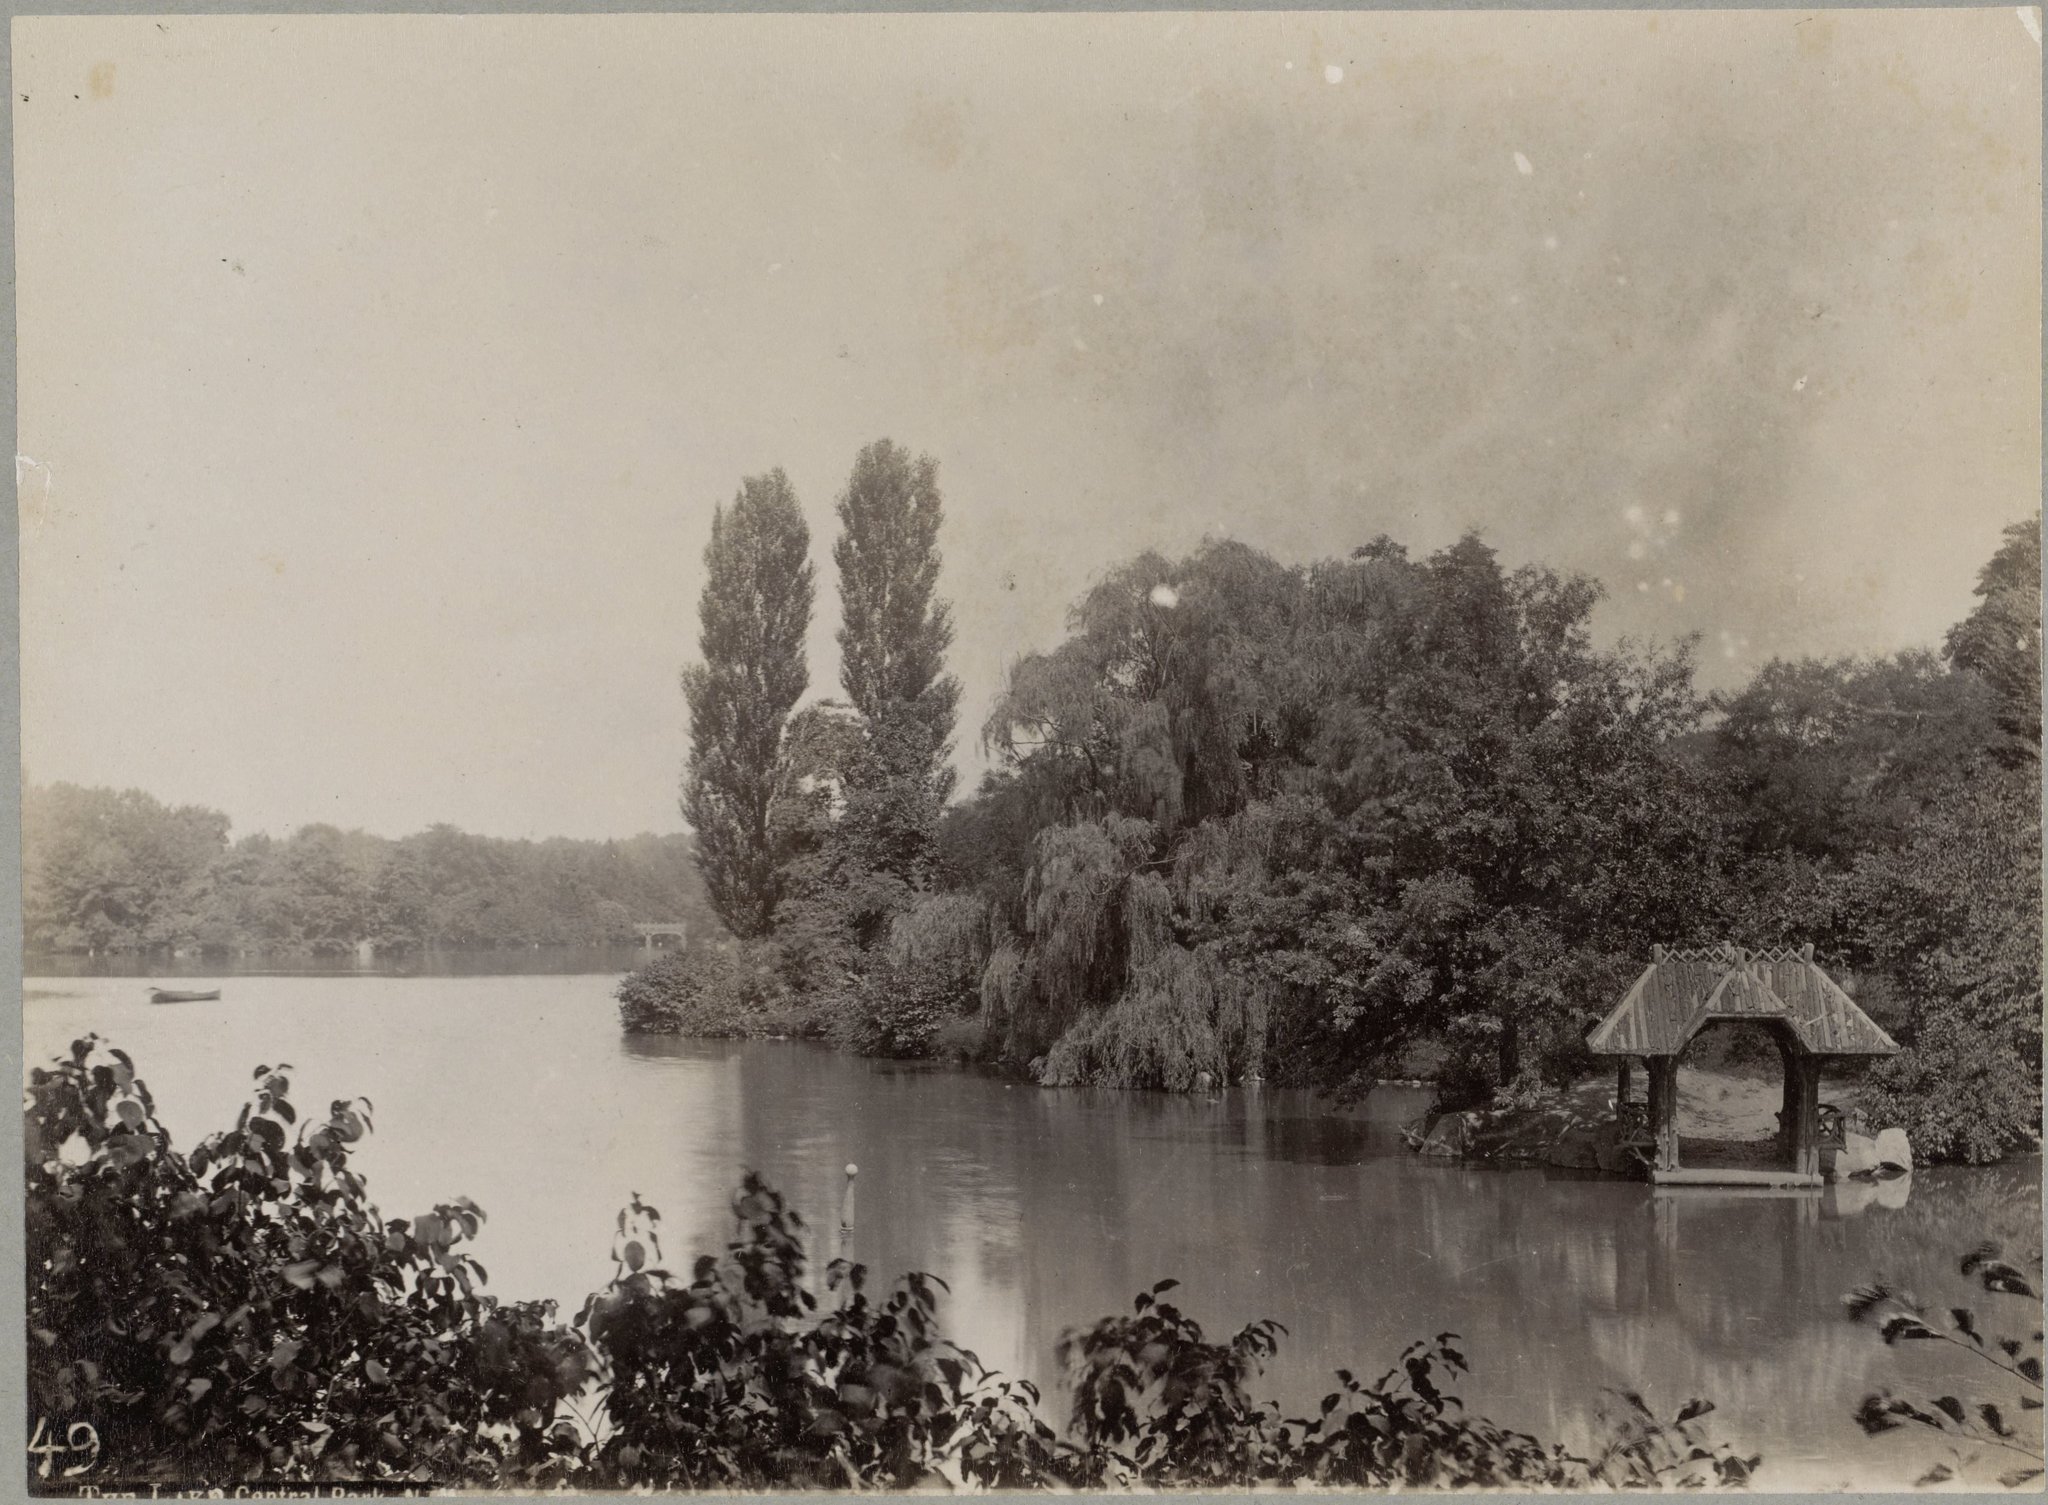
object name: photograph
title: Gezicht op een vijver van Central Park in New York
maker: Anonymous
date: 1880-1900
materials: cardboard, paper, photographic support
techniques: albumen print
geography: new york city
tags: pond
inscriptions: negative number: ‘49’